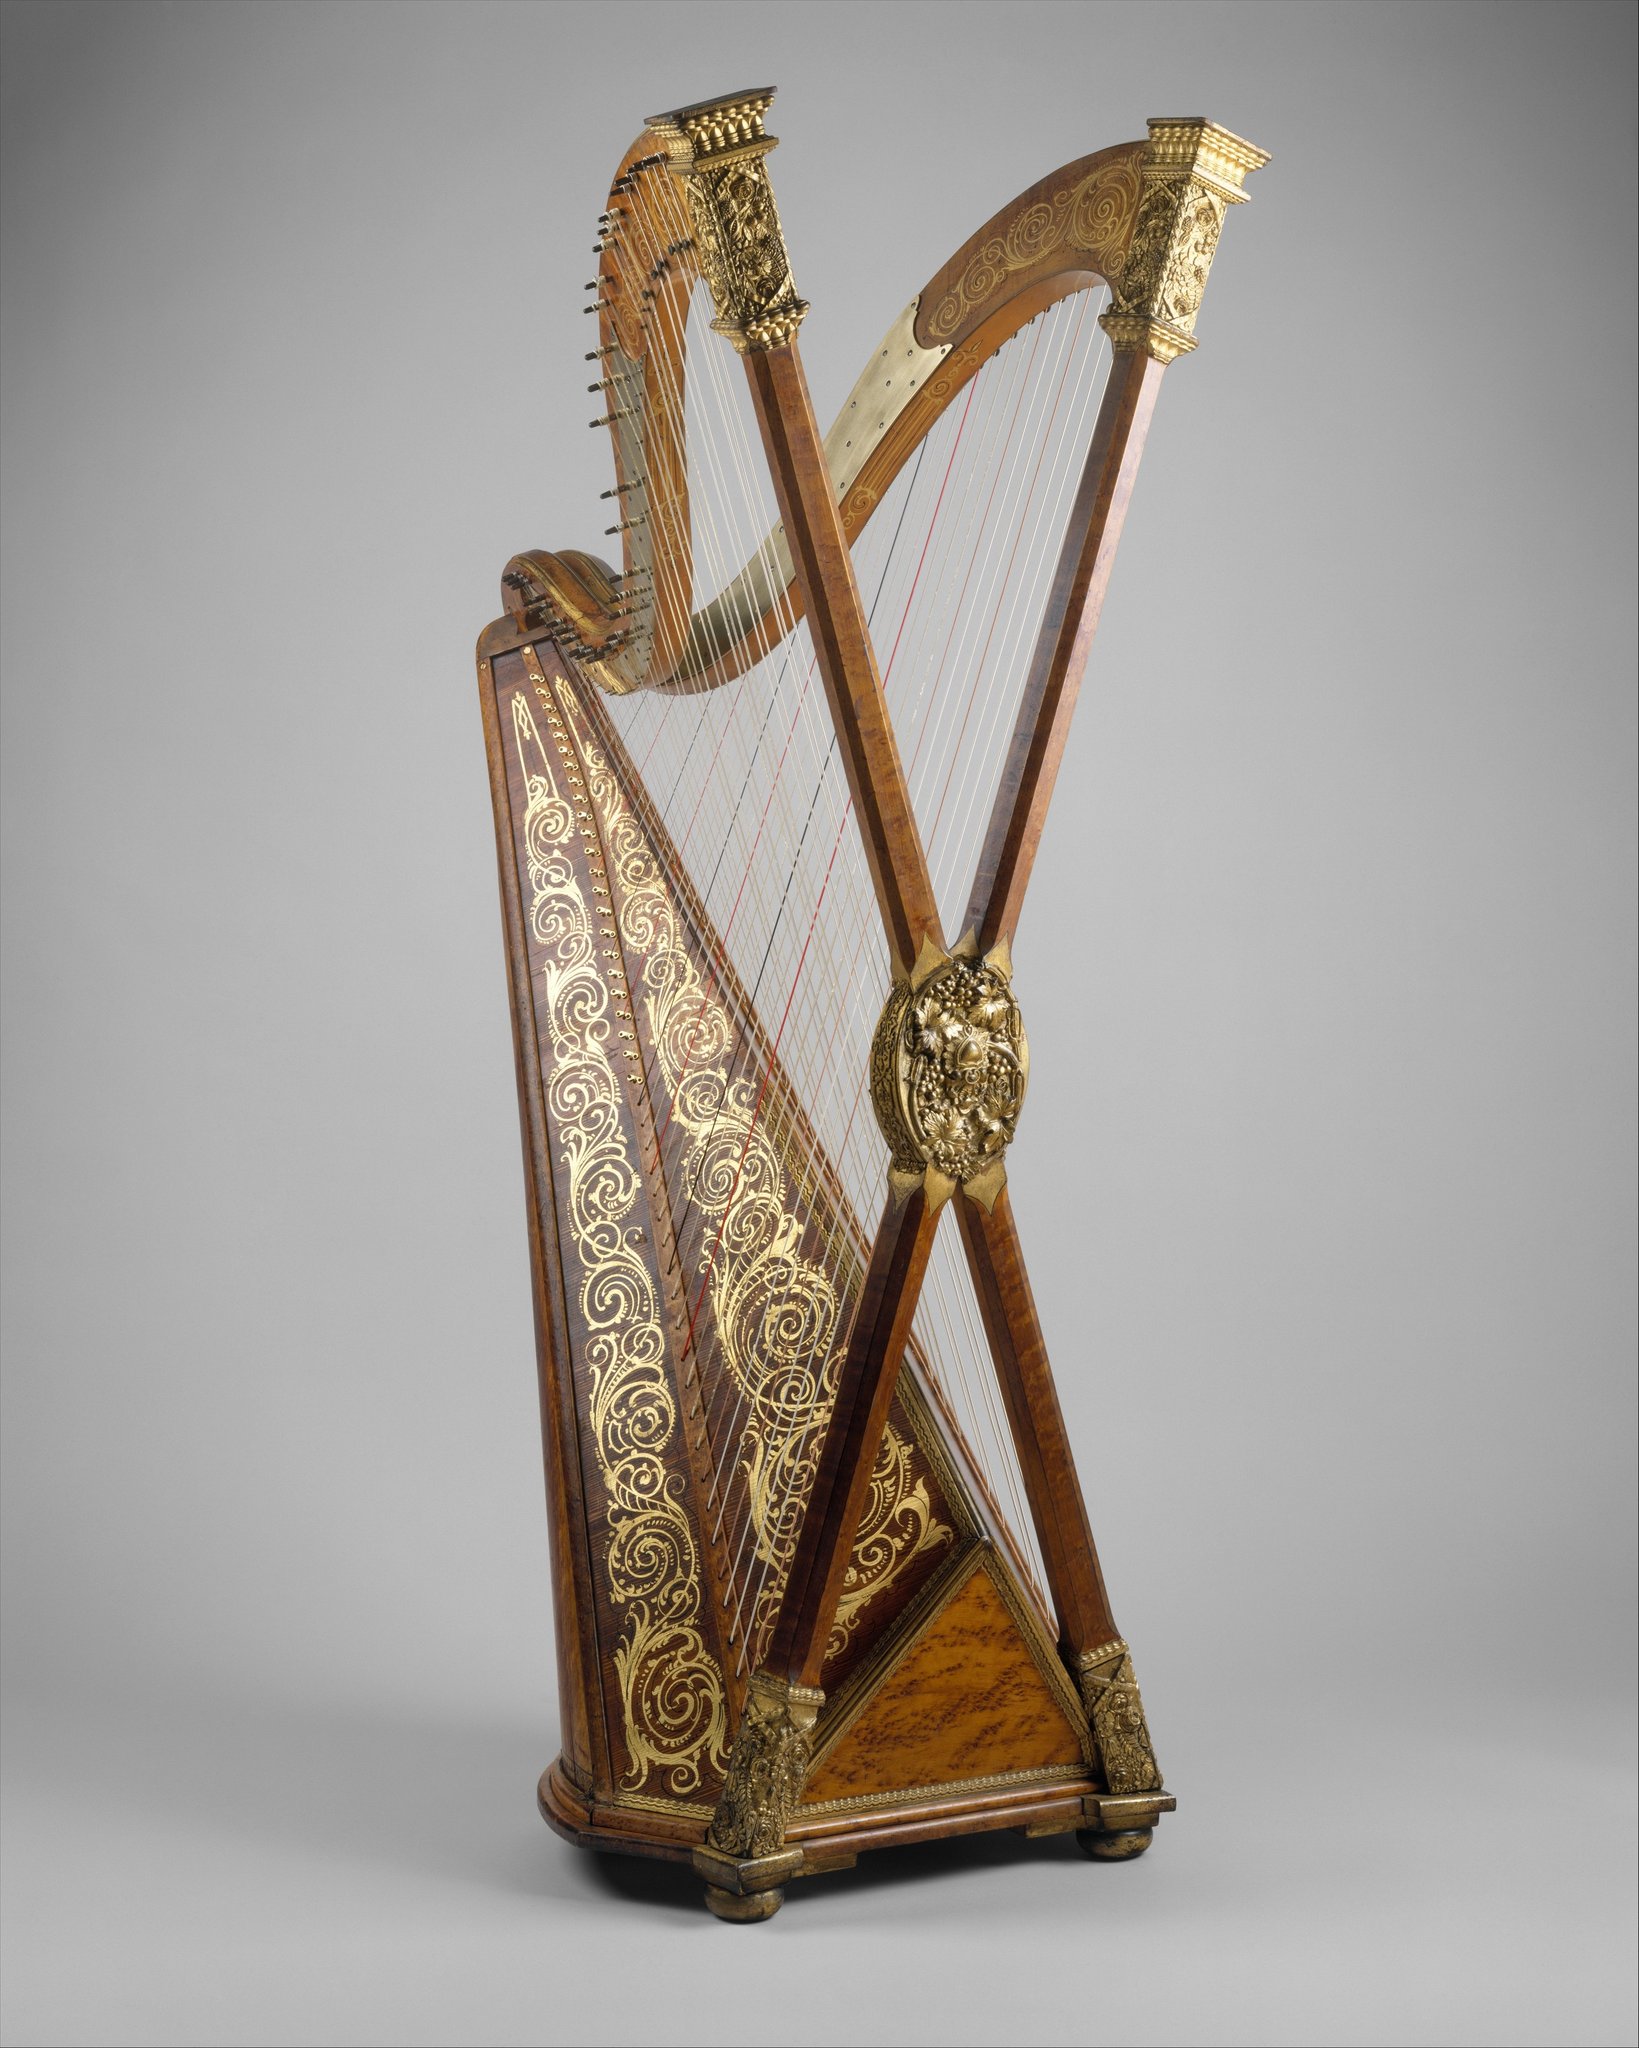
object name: double chromatic harp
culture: american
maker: henry greenway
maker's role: maker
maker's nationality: american, born england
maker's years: 1833-1903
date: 1895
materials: brass, wood, metal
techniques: gilding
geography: united states